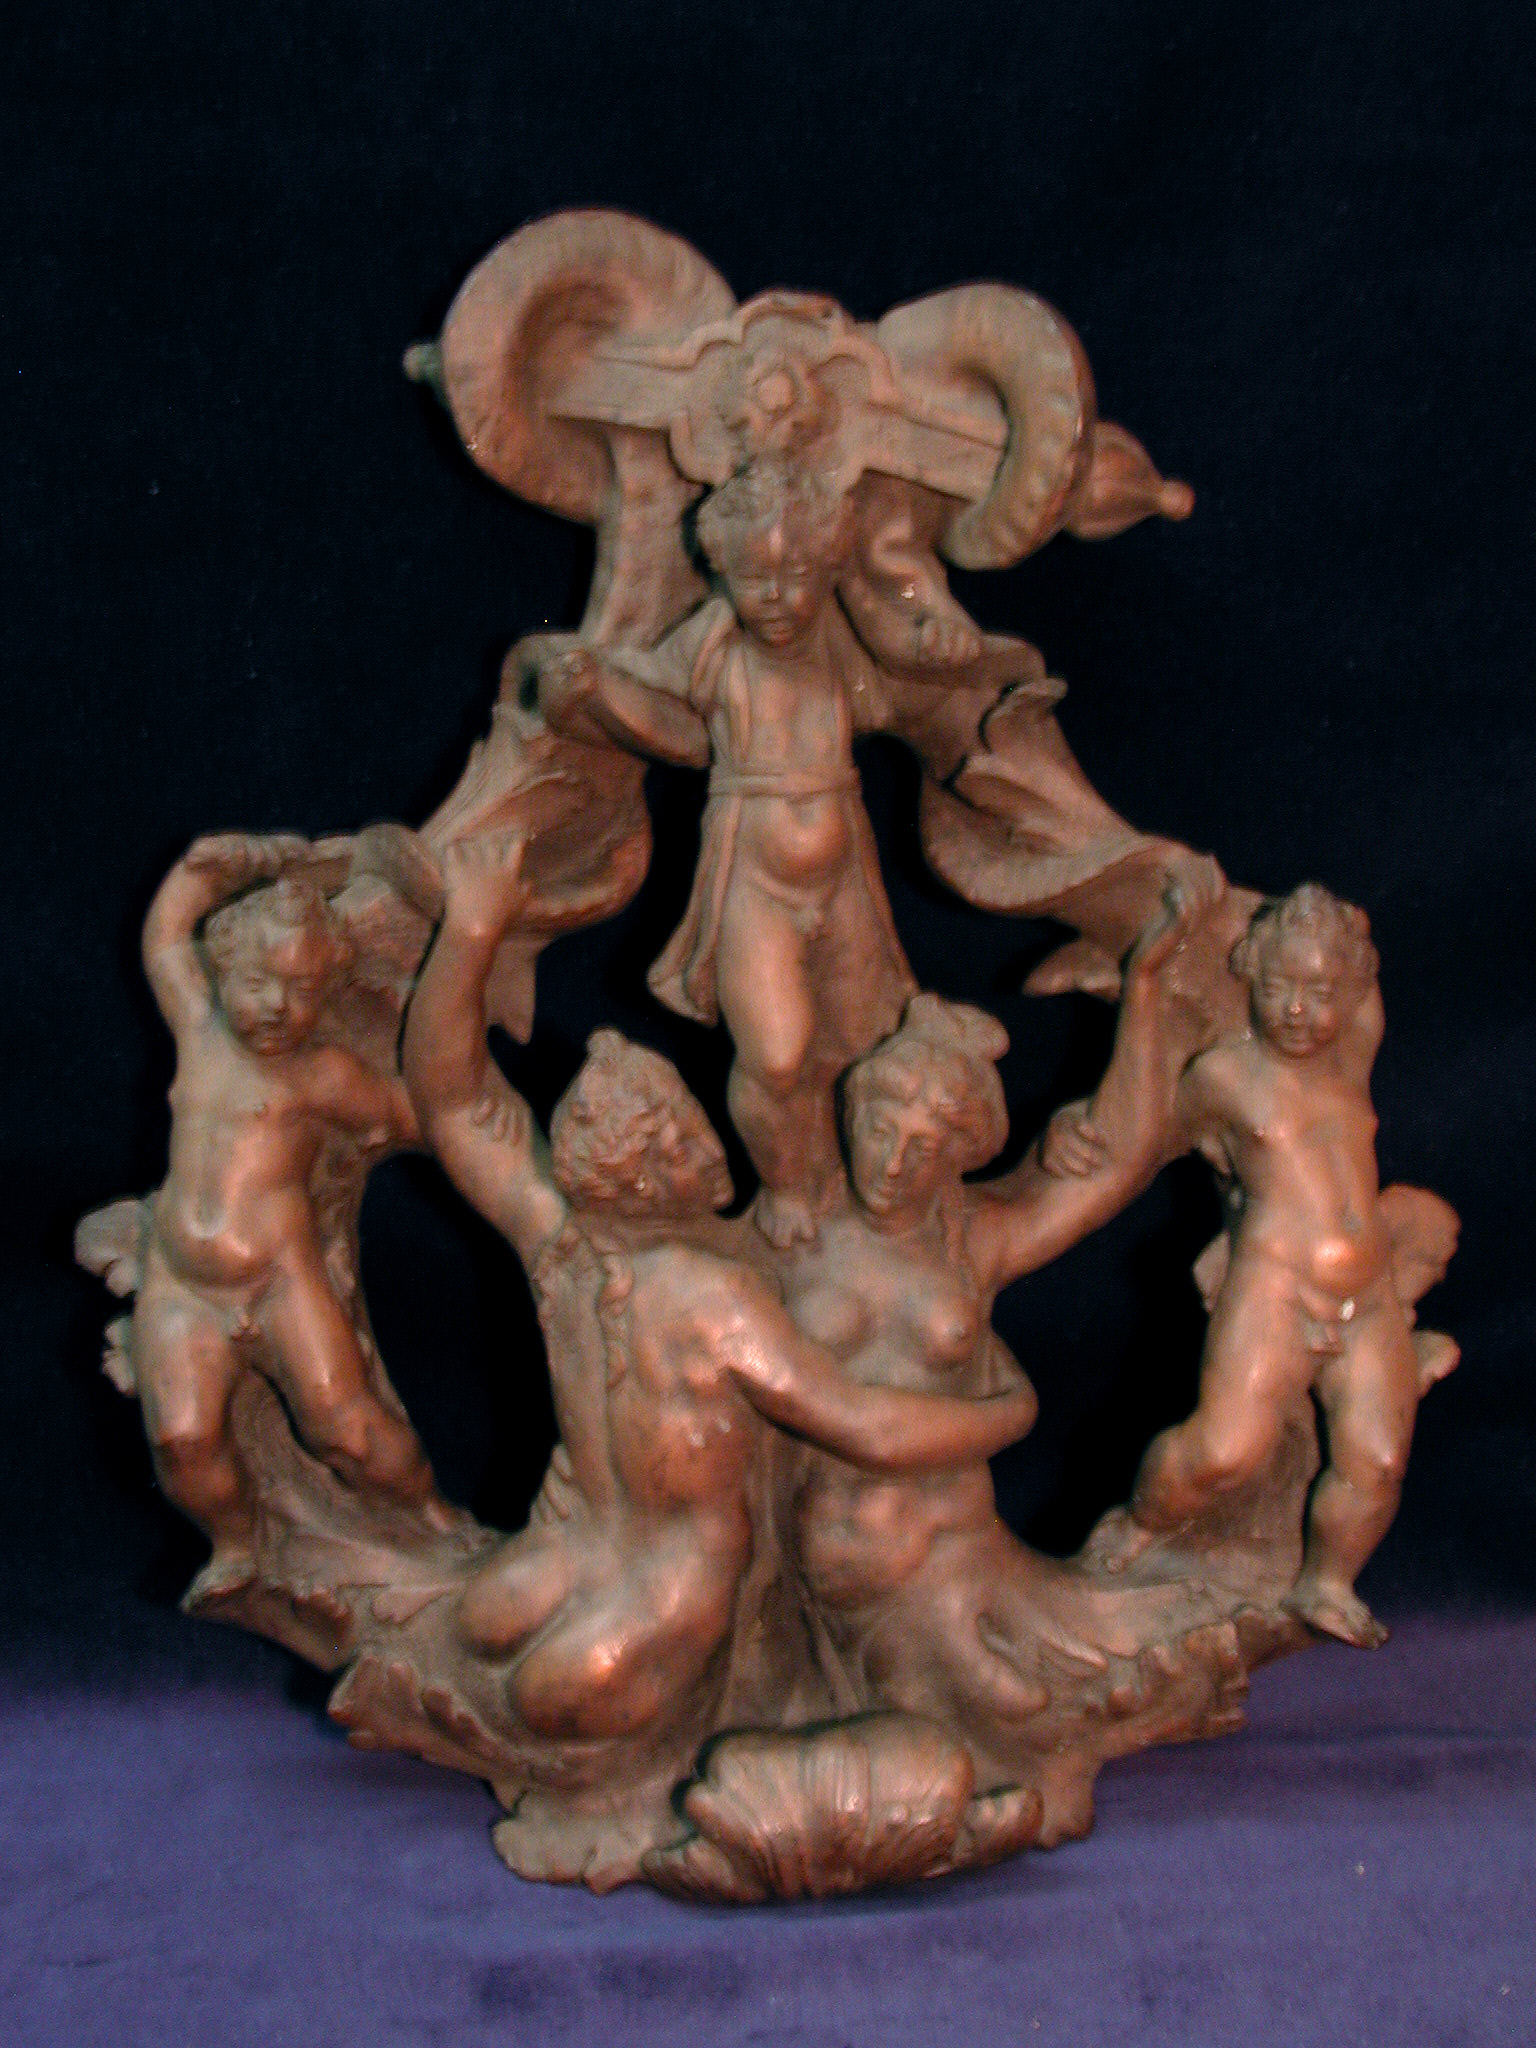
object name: door knocker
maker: danese cattaneo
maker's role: artist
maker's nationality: italian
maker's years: 1512-1572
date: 1801-1900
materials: bronze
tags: boys,female nudes